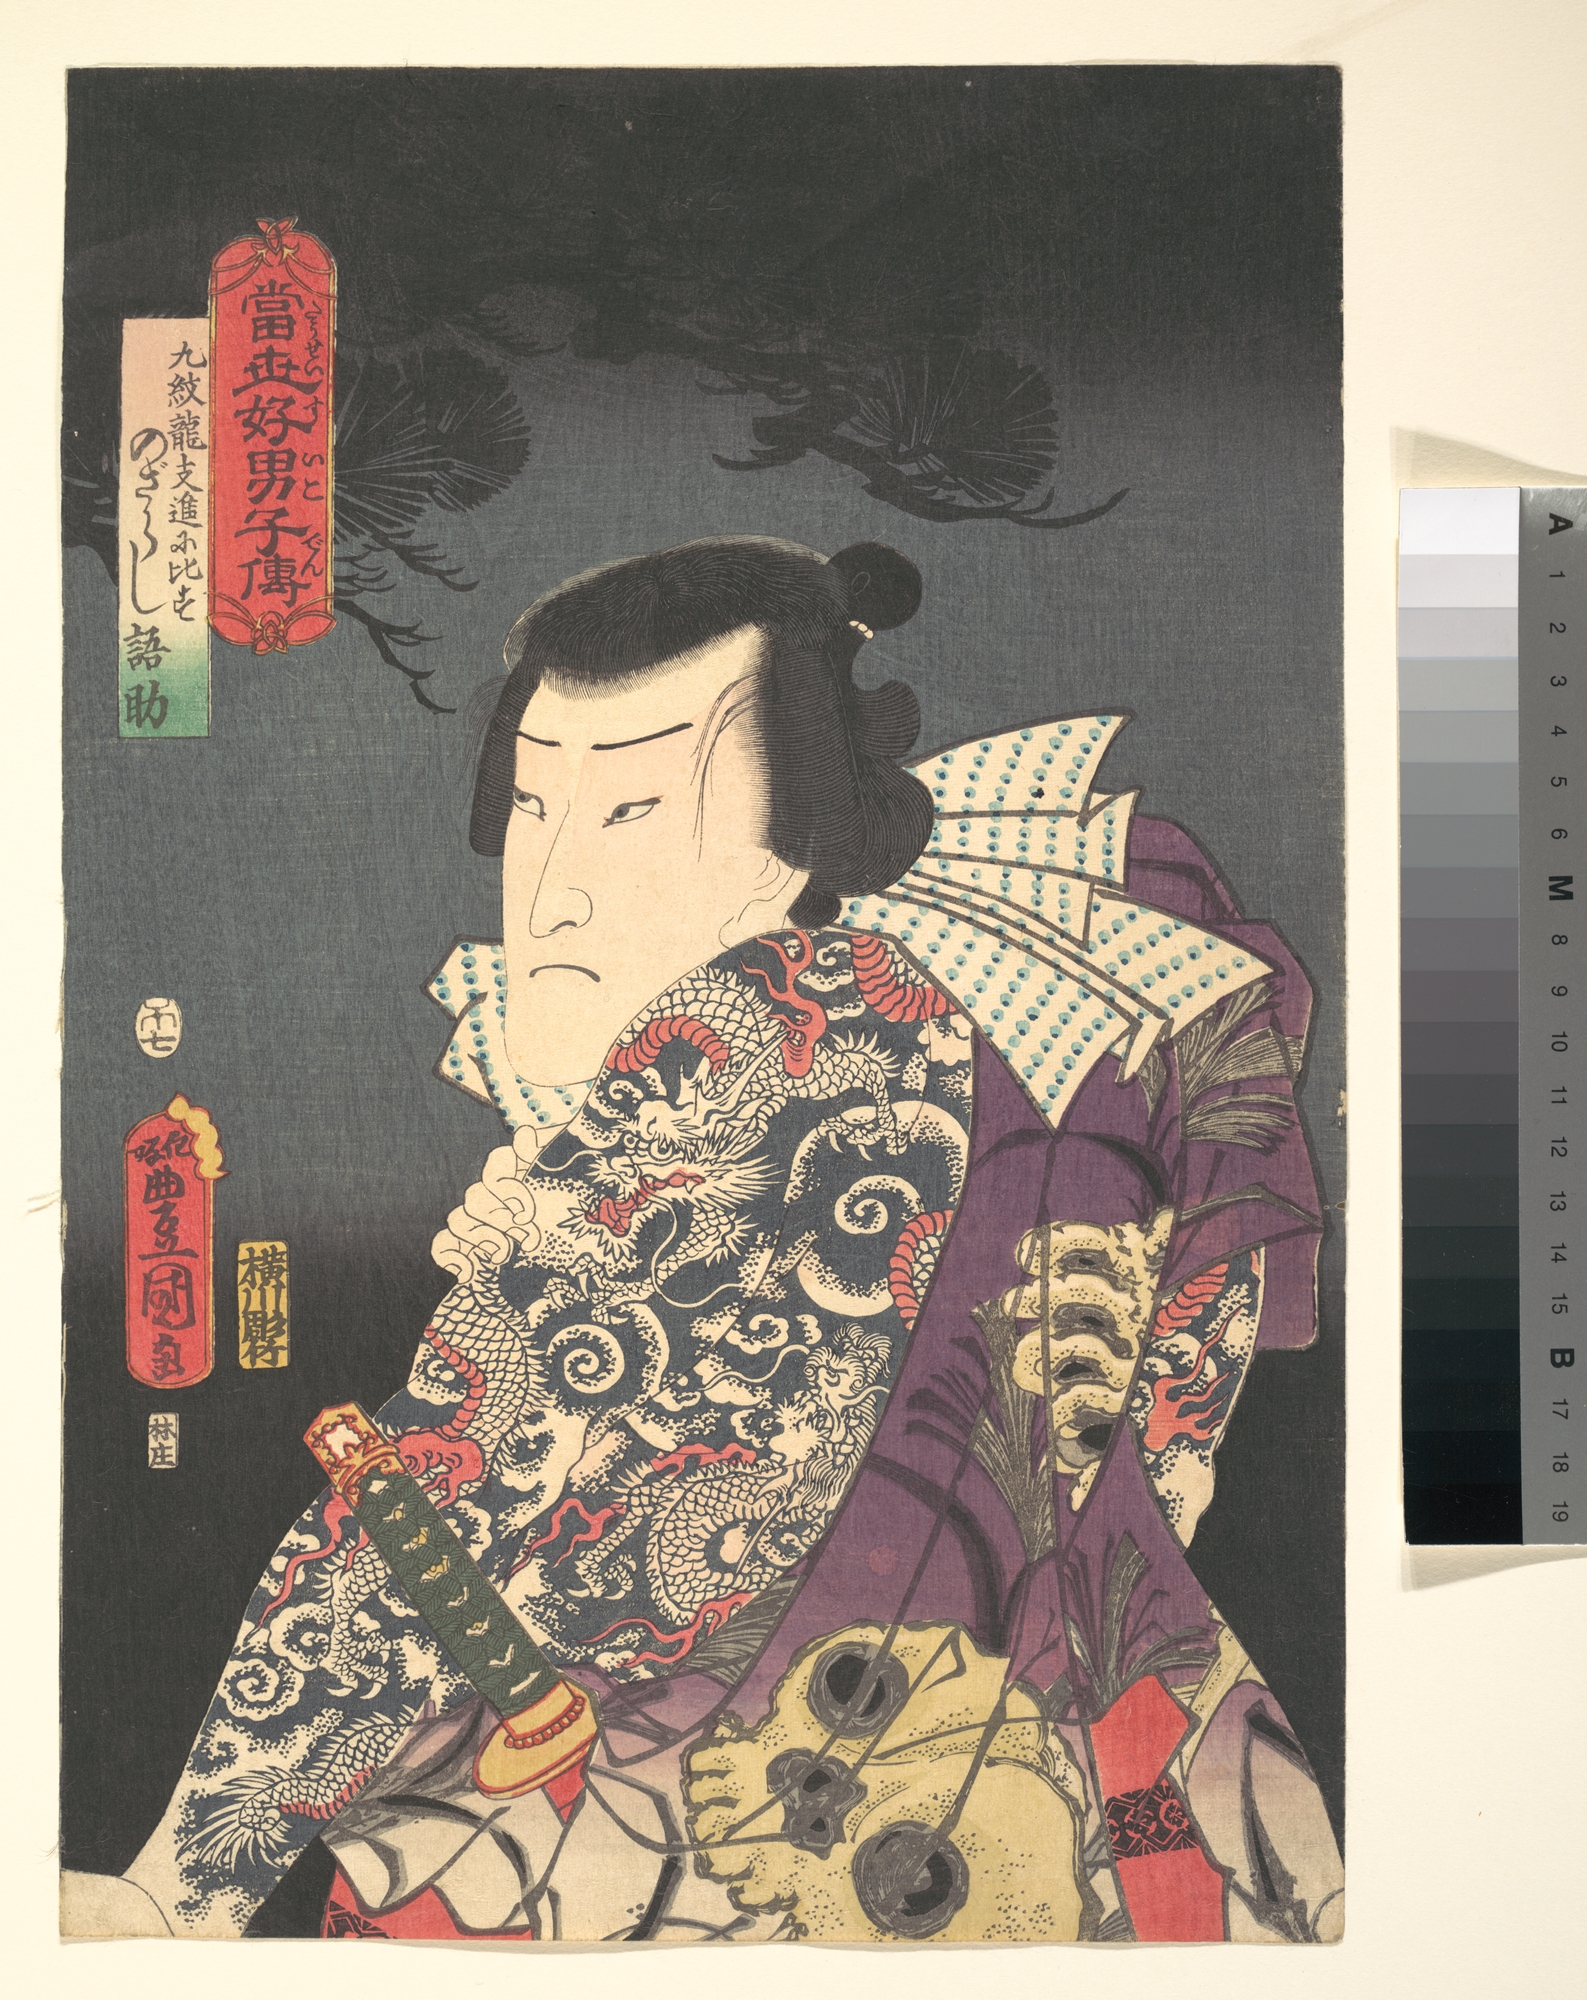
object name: print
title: The Actor Ichikawa Ichizō III as Nozarashi Gosuke, likened to Shi Jin the Nine Dragoned (Kyūmonryū Shishin ni hisu), from the “Pine” triptych of the series A Modern Water Margin (Tōsei suikoden)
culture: japanese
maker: utagawa kunisada 歌川国貞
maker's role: artist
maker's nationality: japanese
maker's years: 1786-1864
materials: ink, paper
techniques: nishiki e, woodblock print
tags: men,actors